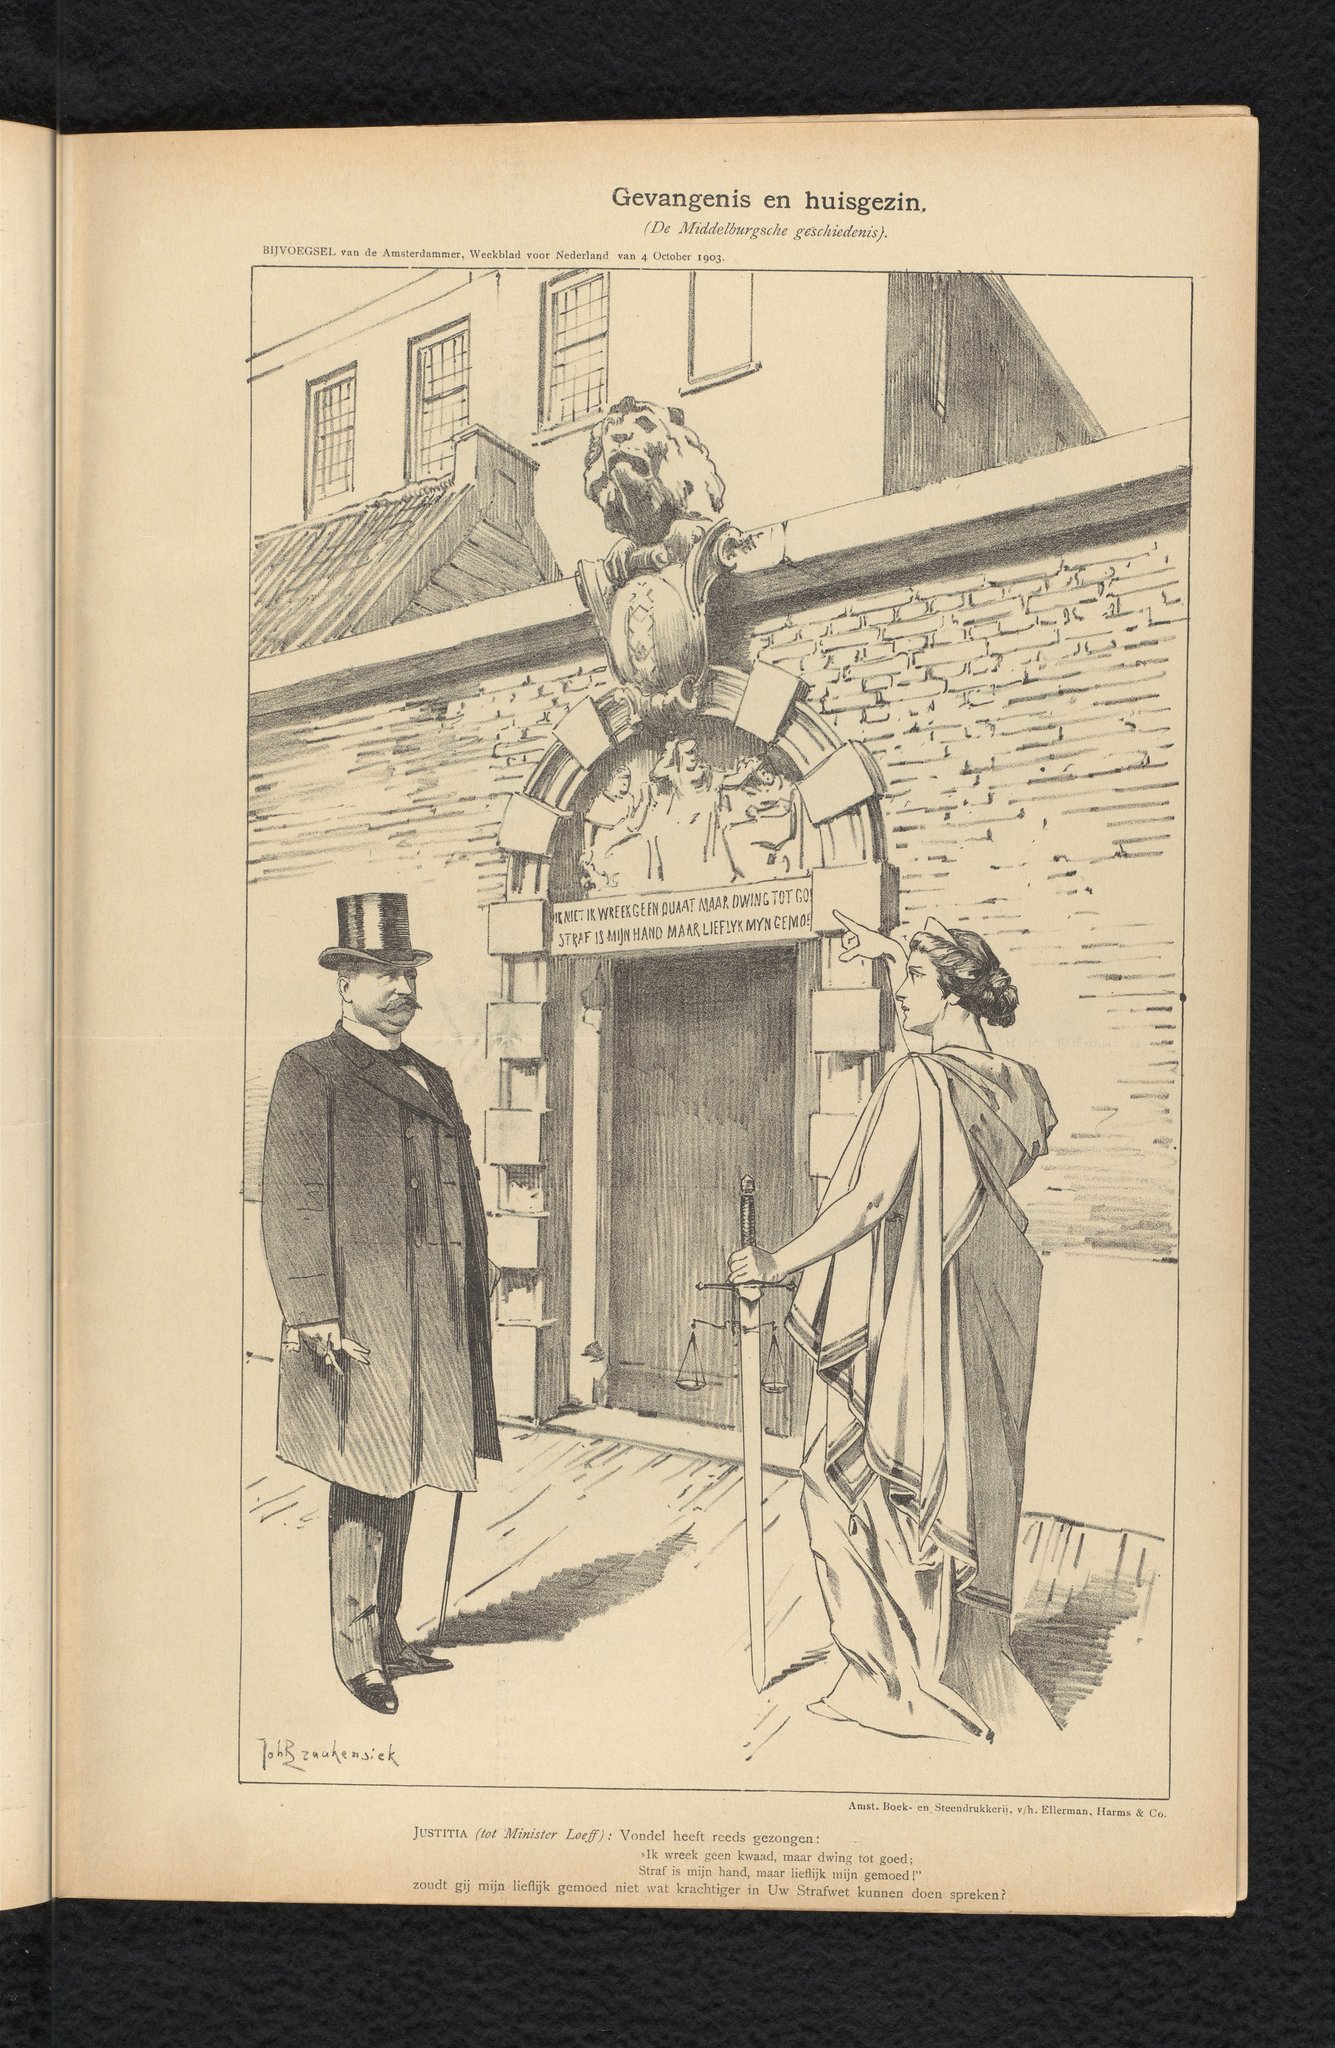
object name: cartoon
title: Gevangenis en huisgezin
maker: johan braakensiek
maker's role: draughtsman, print maker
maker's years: 1858-1940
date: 1903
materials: paper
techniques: lithograph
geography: amsterdam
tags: personifications of countries, nations, states, districts, etc., political caricatures and satires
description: De Nederlandse Maagd vraagt aan minister van Justitie Jan Loeff wat milder in de strafwet te zijn. Beiden staan voor de poort van de vrouwengevangenis Het Spinhuis te Amsterdam. Boven de poort de twee dichtregels van P.C. Hooft (niet Vondel) over mildheid in straffen. Naar aanleiding van het overlijden van een ernstig zieke vrouw in de gevangenis van Middelburg op 2-3 september, ondanks herhaalde verzoeken aan de minister om vrijstelling.